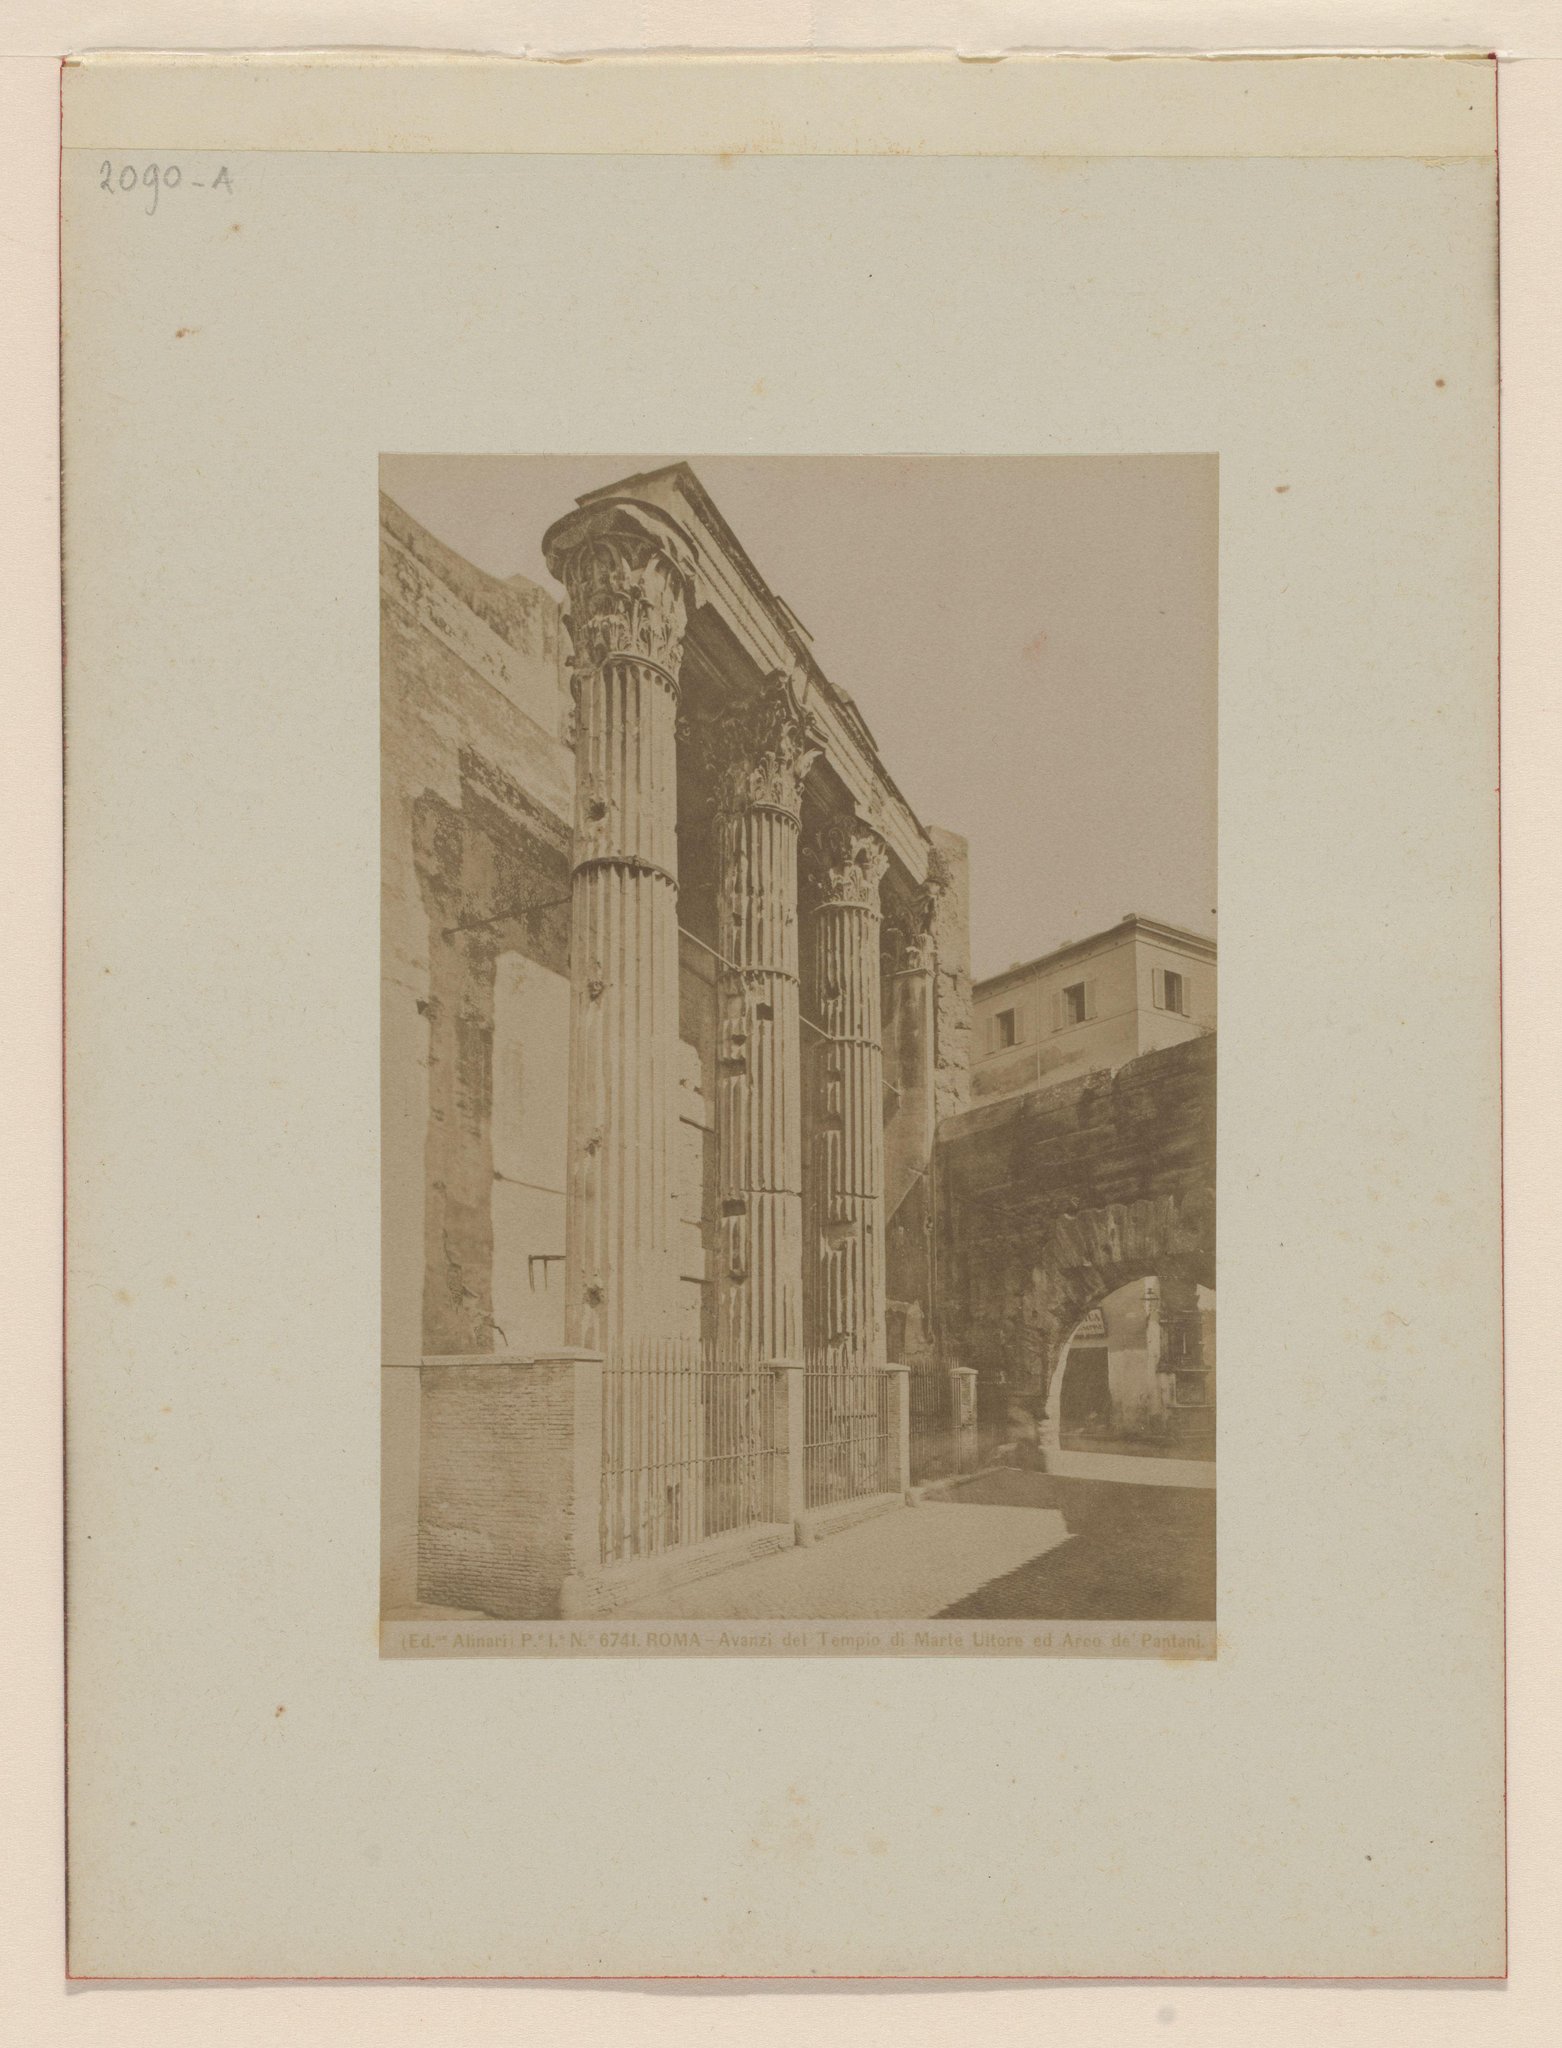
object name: photograph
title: Roma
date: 1857-1900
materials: cardboard, paper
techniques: albumen print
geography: rome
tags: ruin of a building ~ architecture, temple, shrine ~ roman religion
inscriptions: number: ‘Pe. Io. No. 6741.’